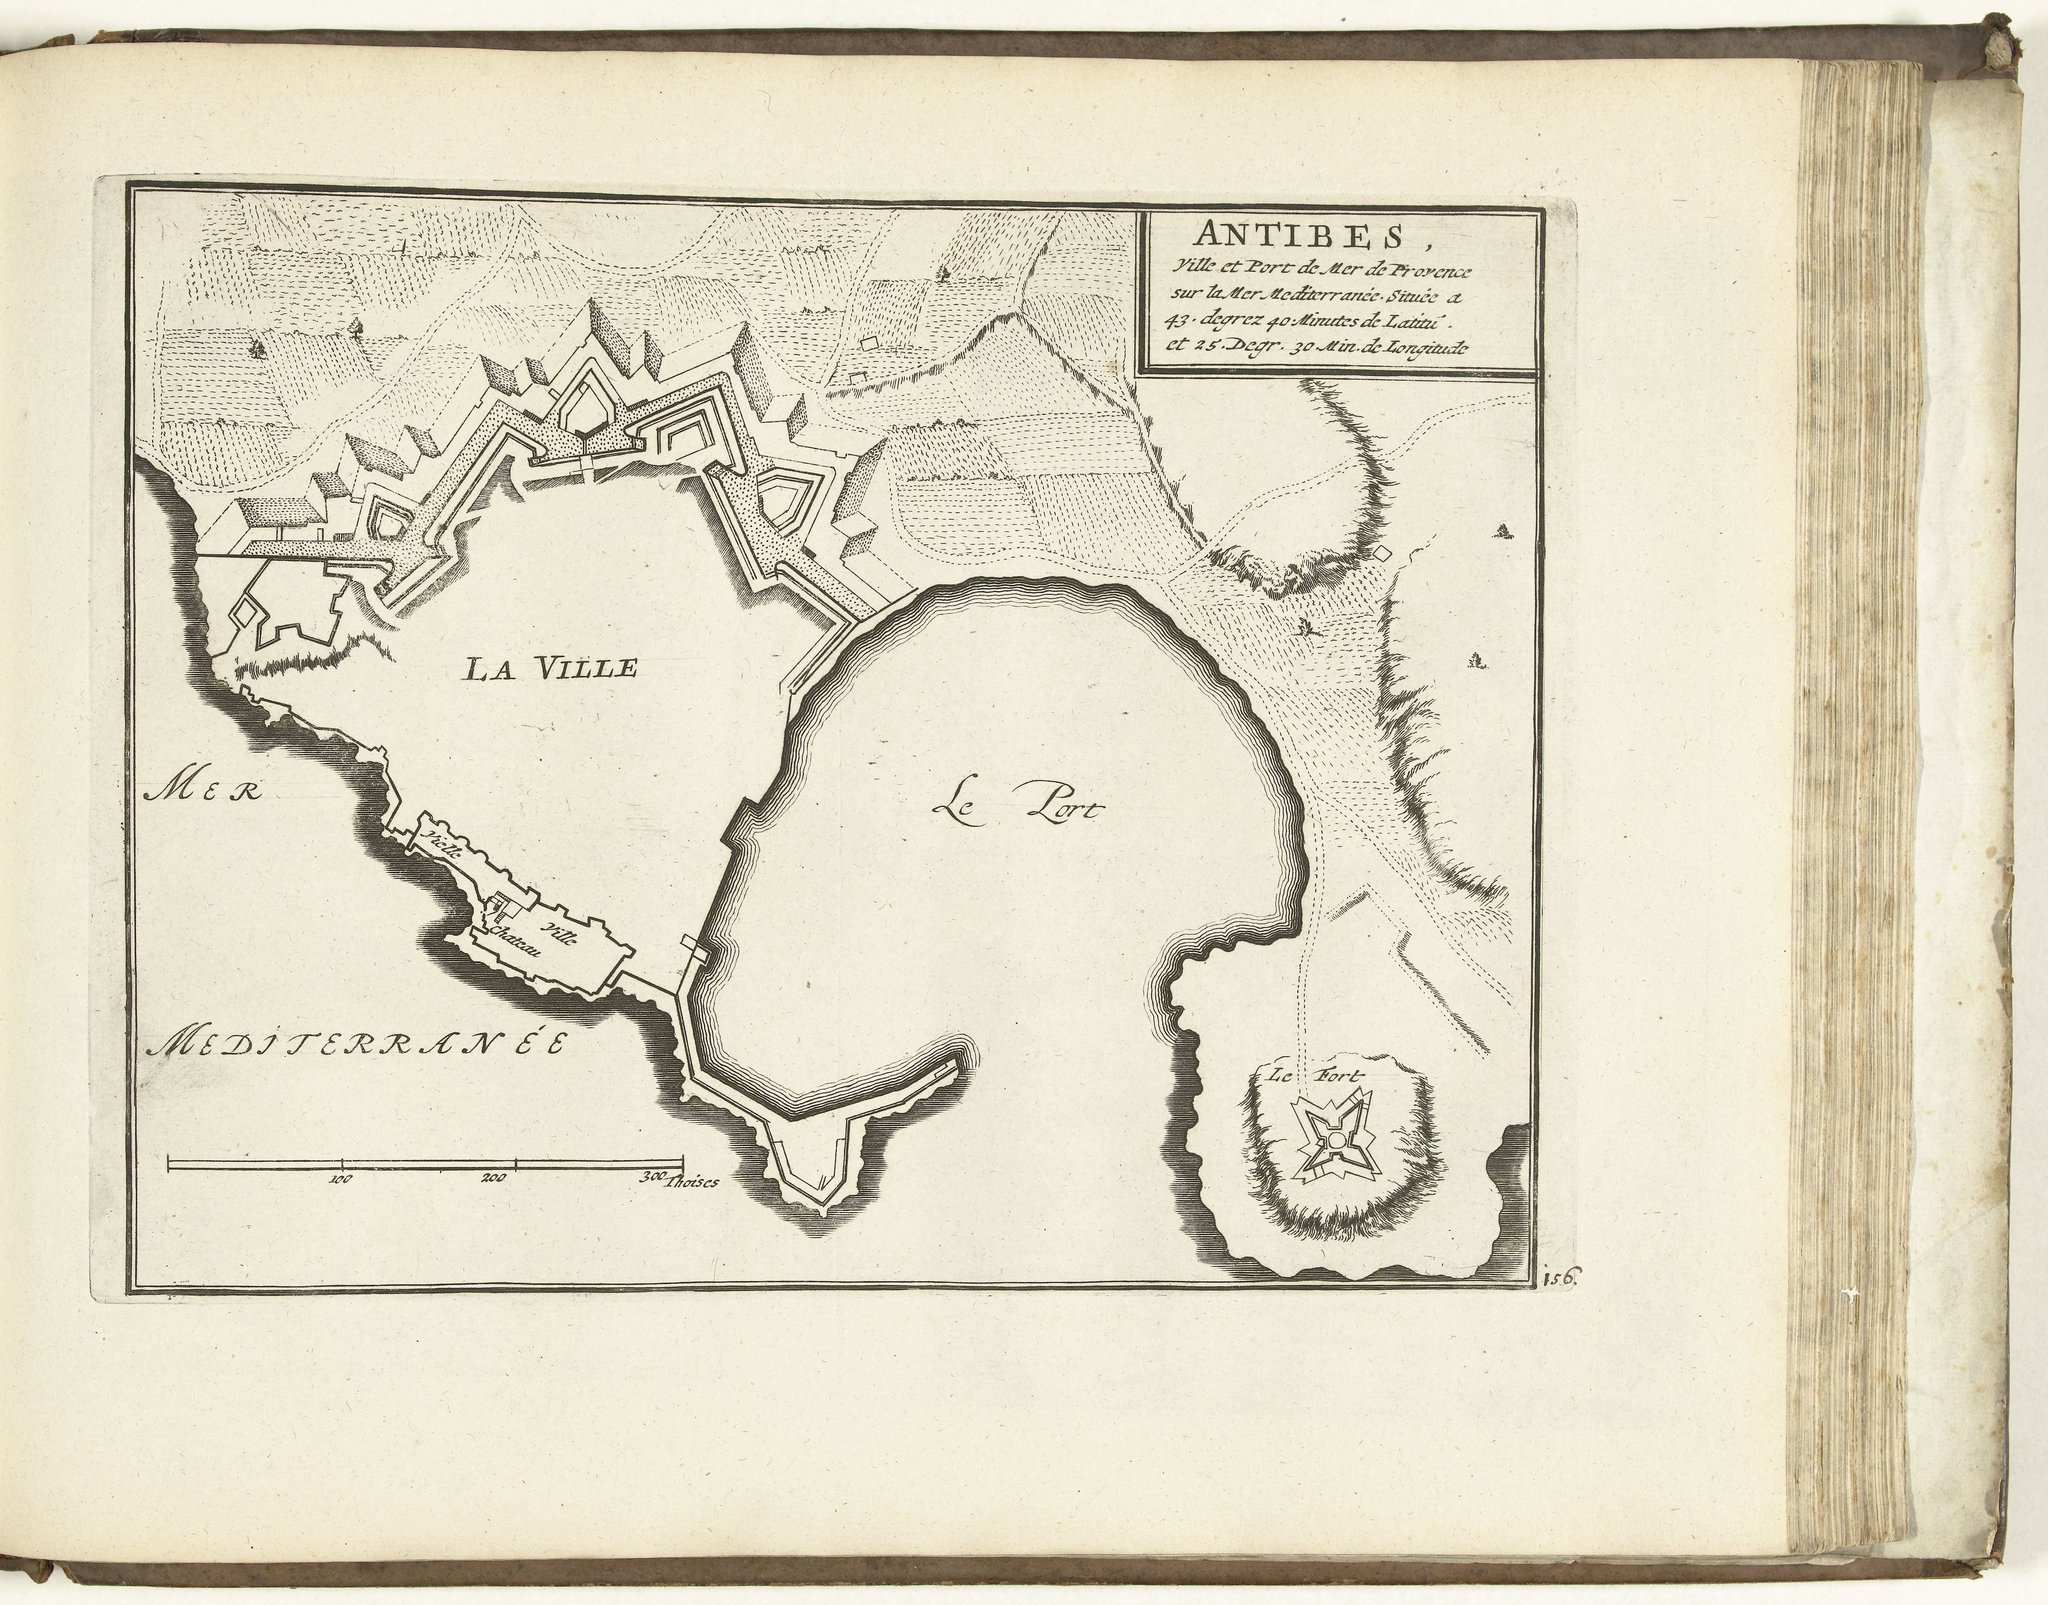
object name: print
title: Antibes, Ville et Port de Mer de Provence (...)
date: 1726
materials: paper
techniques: engraving, etching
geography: northern netherlands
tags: fortress, maps of cities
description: Plattegrond van de versterkingen om de Franse stad Antibes. Plaat nr. 156 in deel VII van het prentwerk: Les Forces de l'Europe, Asie, Afrique et Amerique ... Comme aussi les Cartes des Côtes de France et d'Espagne uit 1726, dit eerste deel met 238 met de hand genummerde platen van vermaarde sterke steden en vestingen in het kader van de Spaanse Successieoorlog 1701-1713. Voor het merendeel zijn deze platen gekopieerd naar de anonieme Franse platen van vermaarde sterke steden en vestingen: in Les forces de l'Europe en in: Le theatre de la guerre, dans les Pays-Bas, beide oorspronkelijk uitgegeven door Nicolas de Fer te Parijs (1693-1697) in het kader van de Negenjarige Oorlog. Titel en opschriften in het Frans.